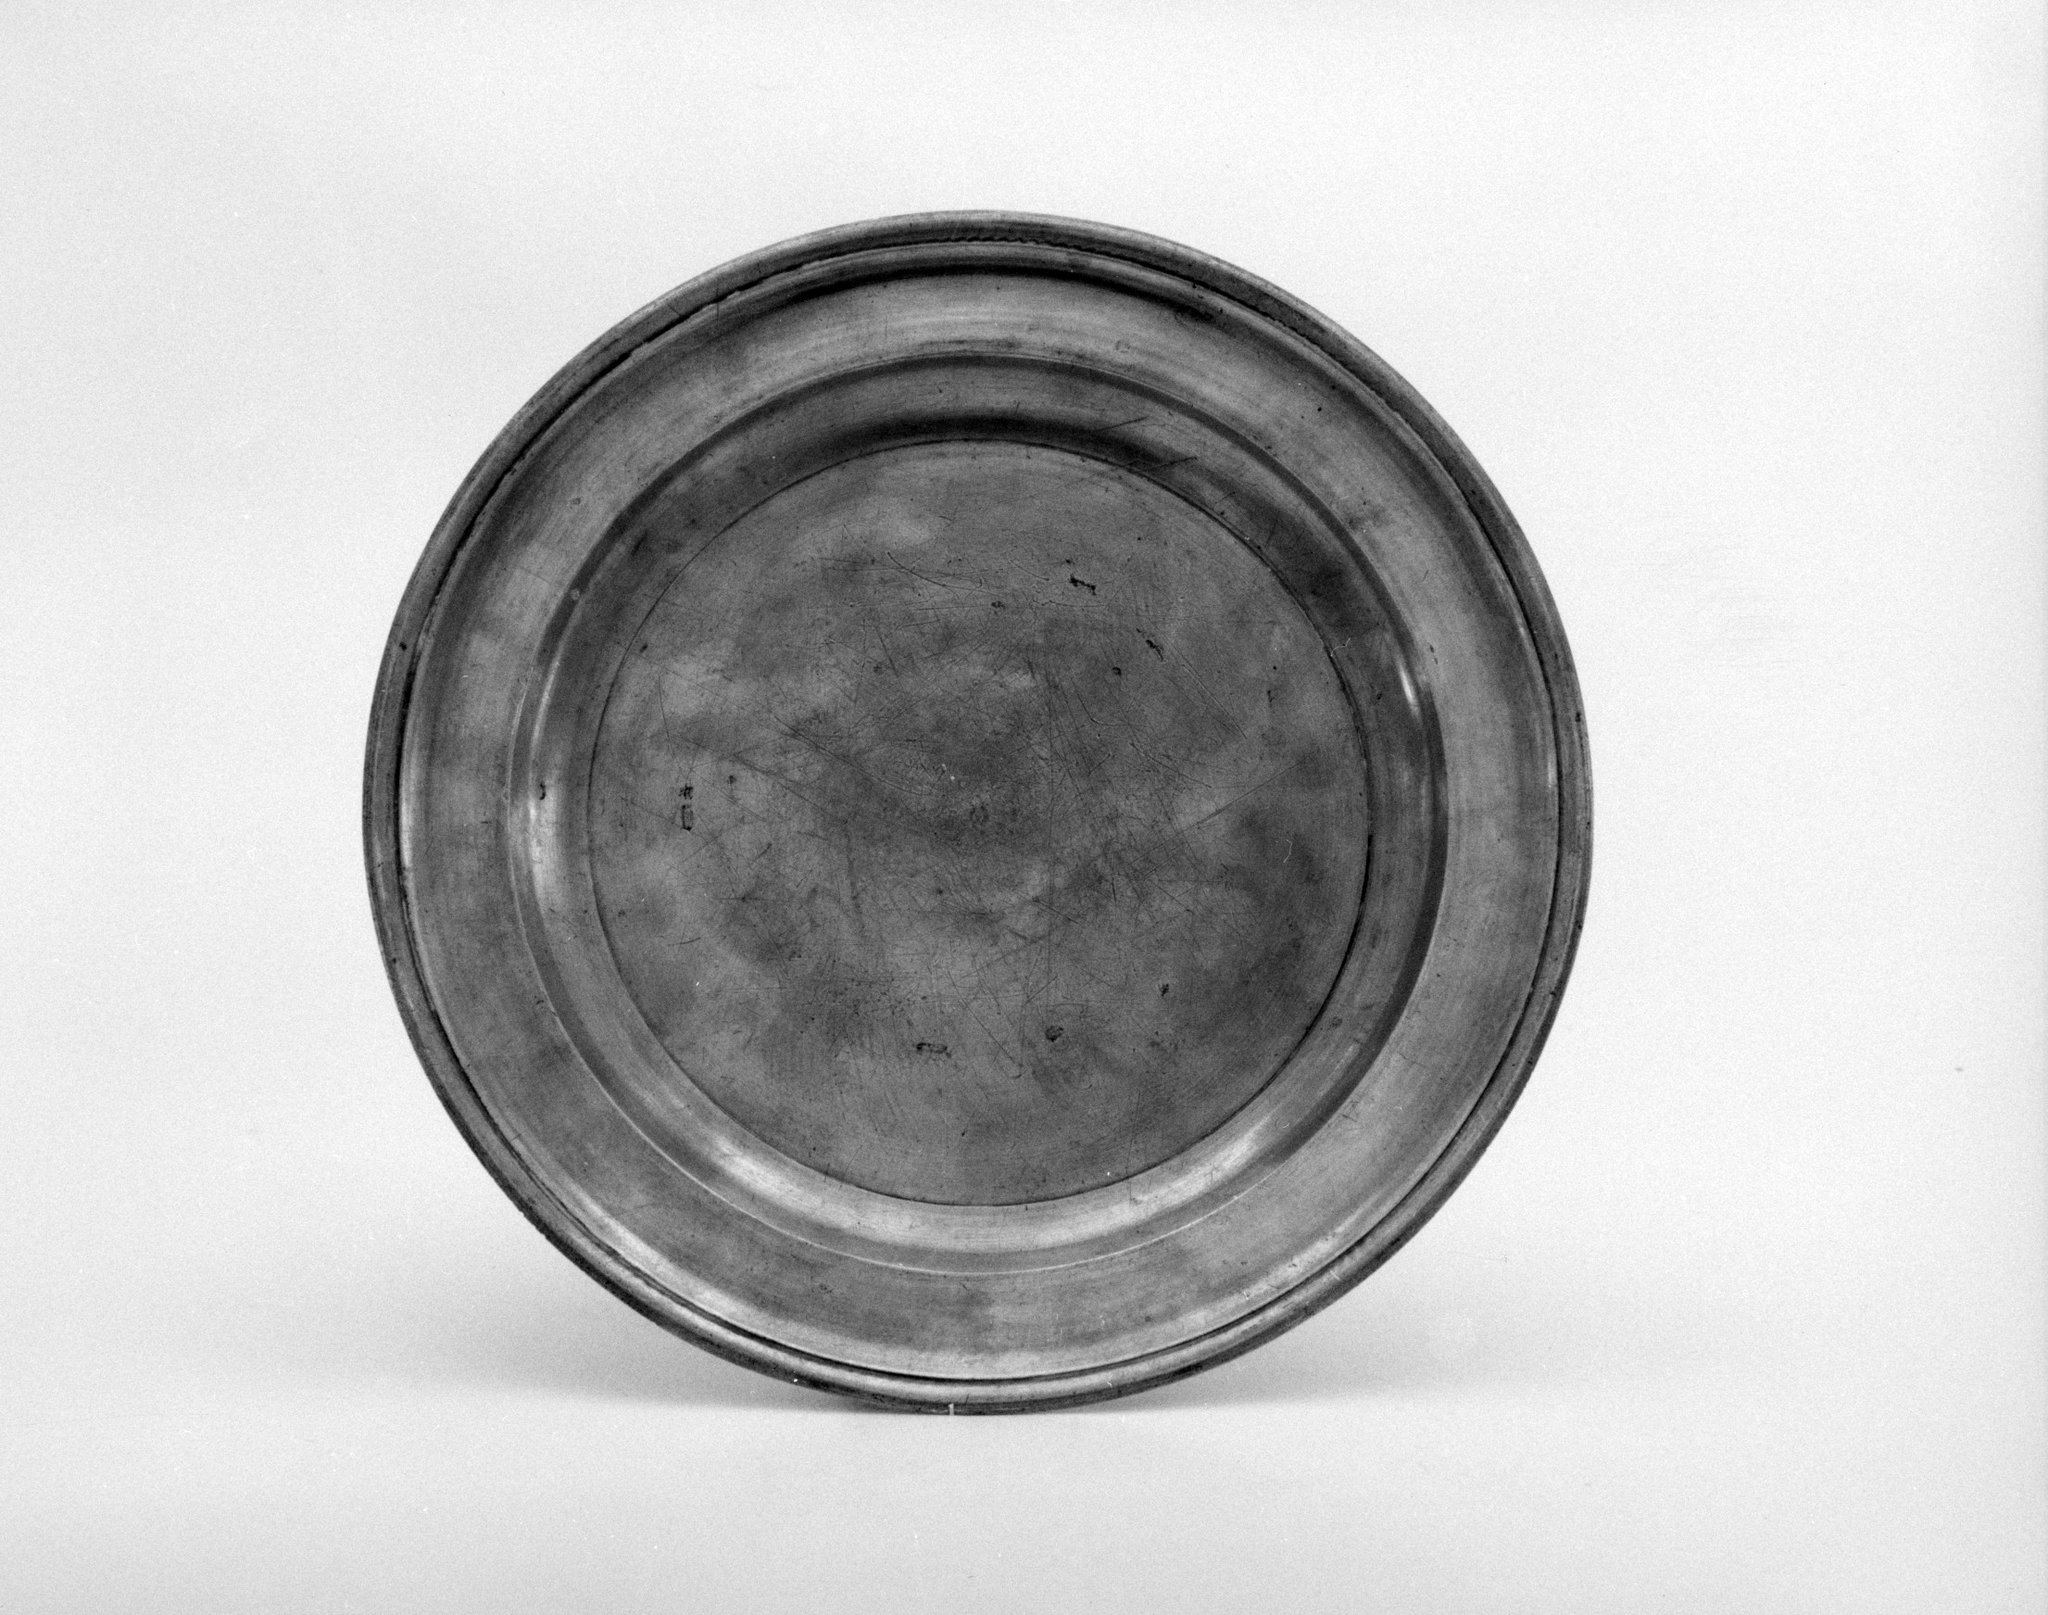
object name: plate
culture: american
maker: gershom jones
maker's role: maker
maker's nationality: american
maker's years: 1751-1809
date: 1774-1809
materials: pewter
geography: united states